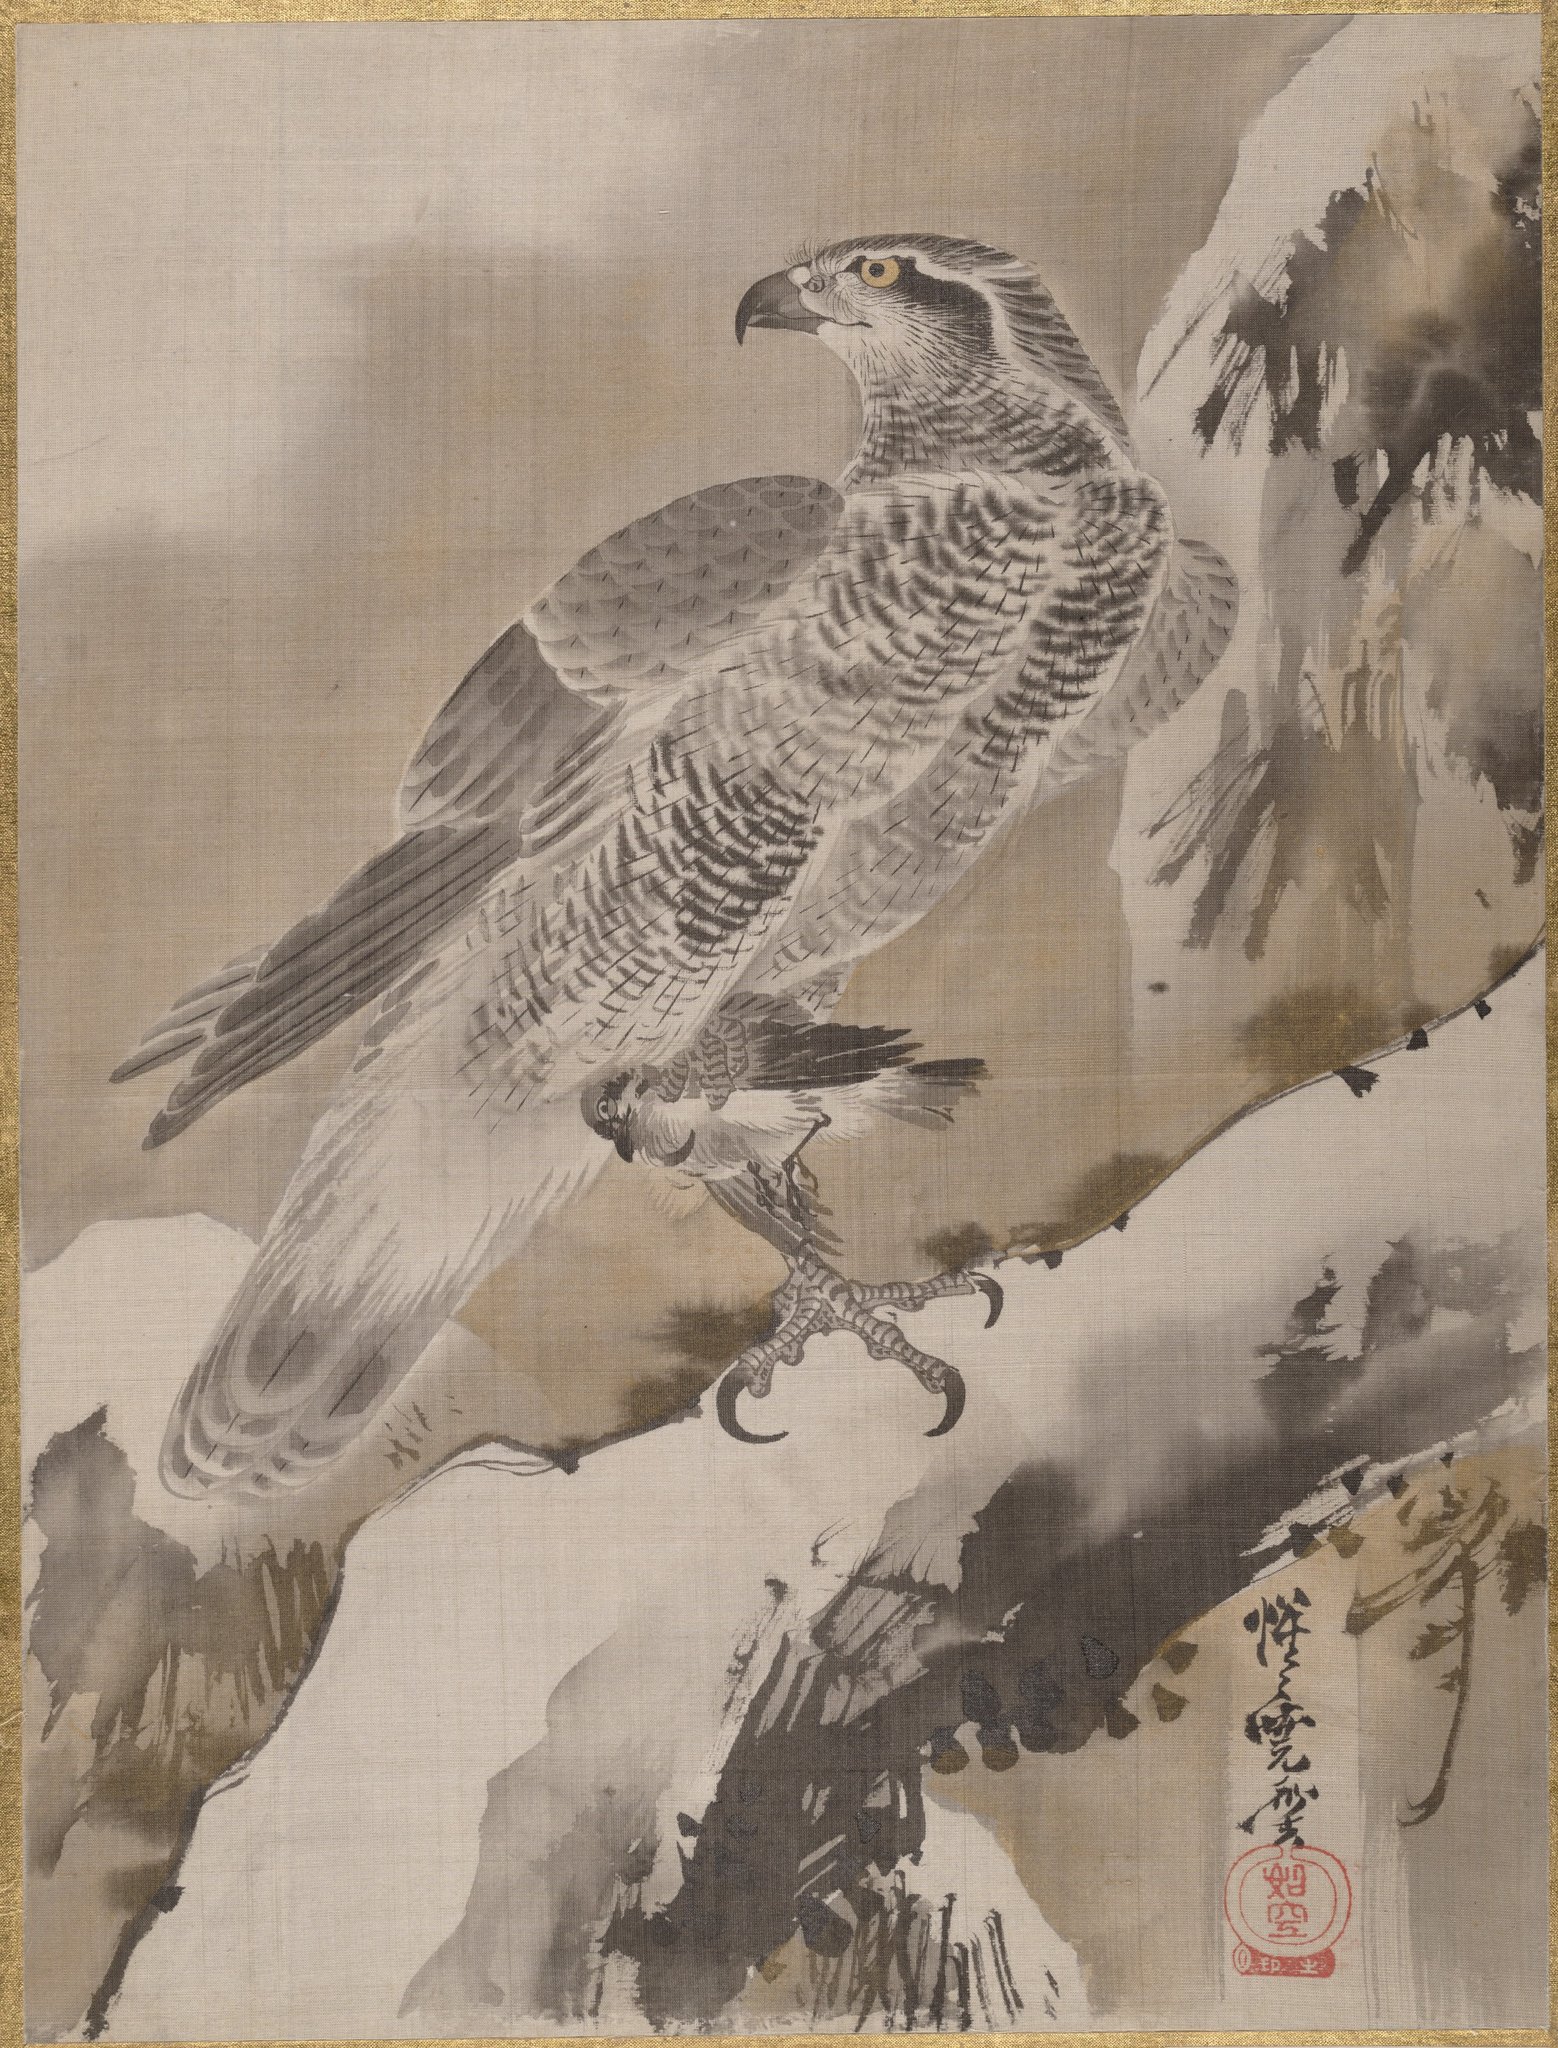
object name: album leaf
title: Eagle Holding Small Bird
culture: japanese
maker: kawanabe kyōsai 河鍋暁斎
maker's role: artist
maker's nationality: japanese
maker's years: 1831-1889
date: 1887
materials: ink, silk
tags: birds,eagles